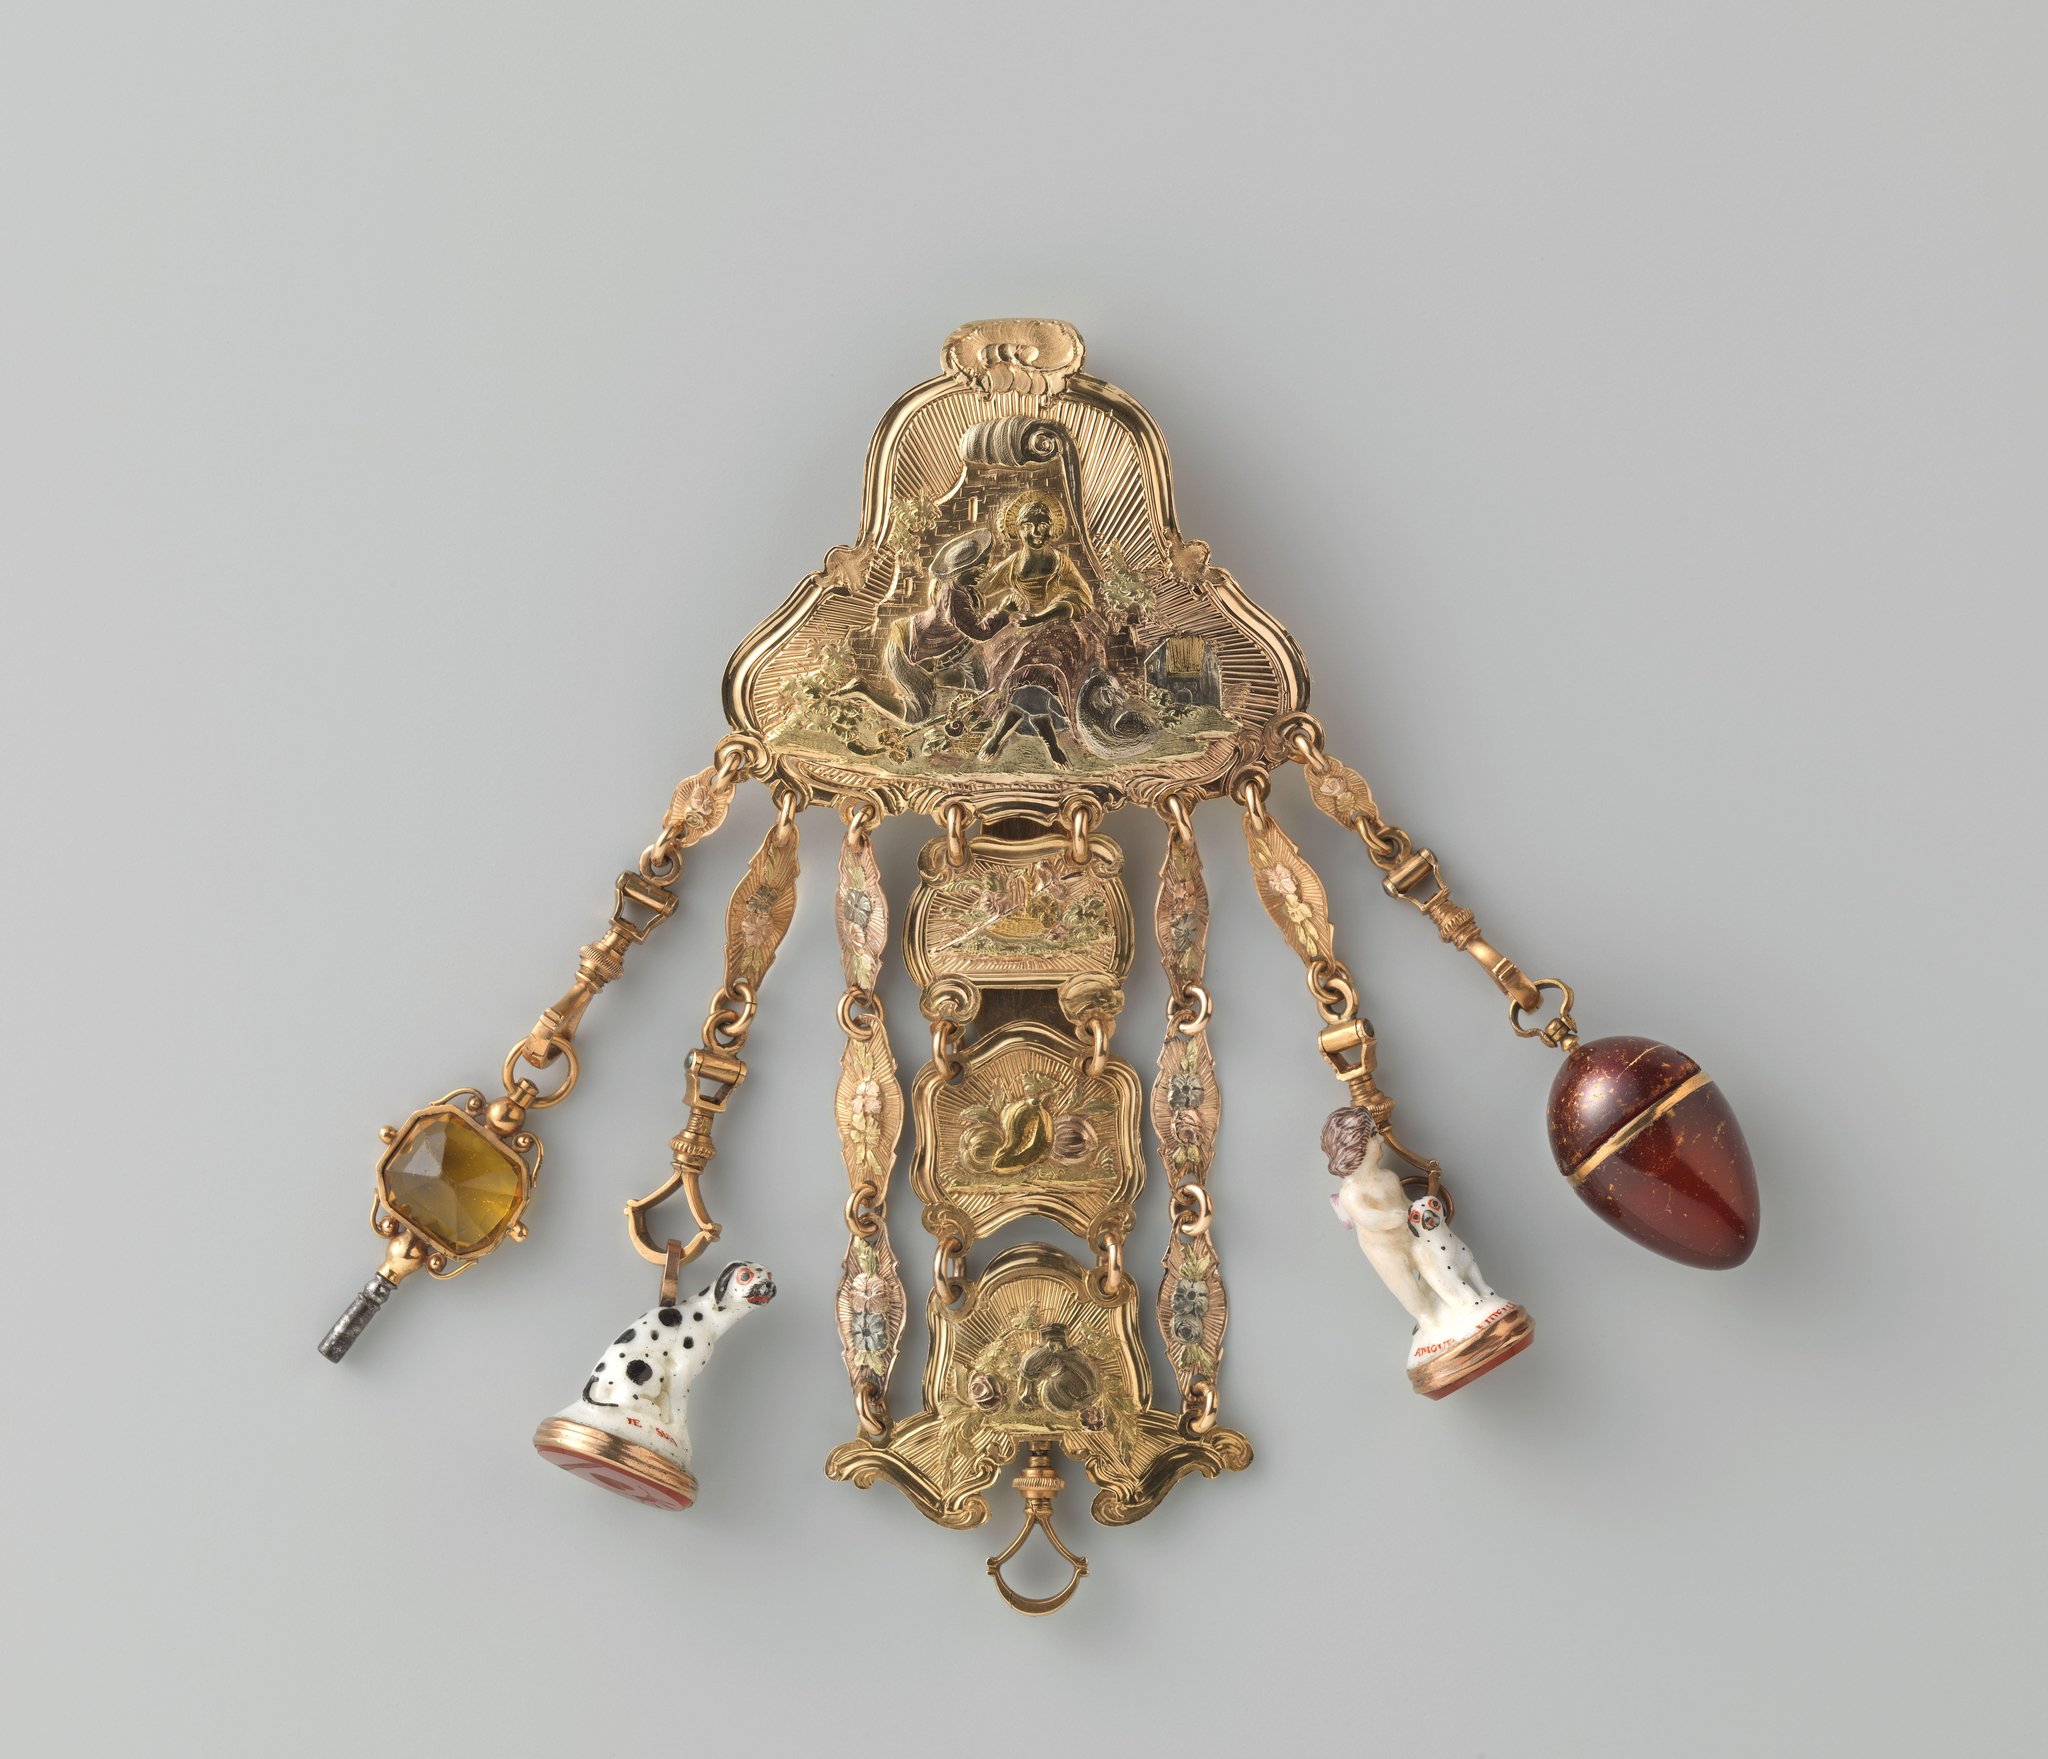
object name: chatelaine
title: Pocket watch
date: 1755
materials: gold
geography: paris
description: Op de gouden chatelaine staan een voorstelling van een herder en een herderin. Hoort bij een gouden horloge (BK-NM-11238-1).